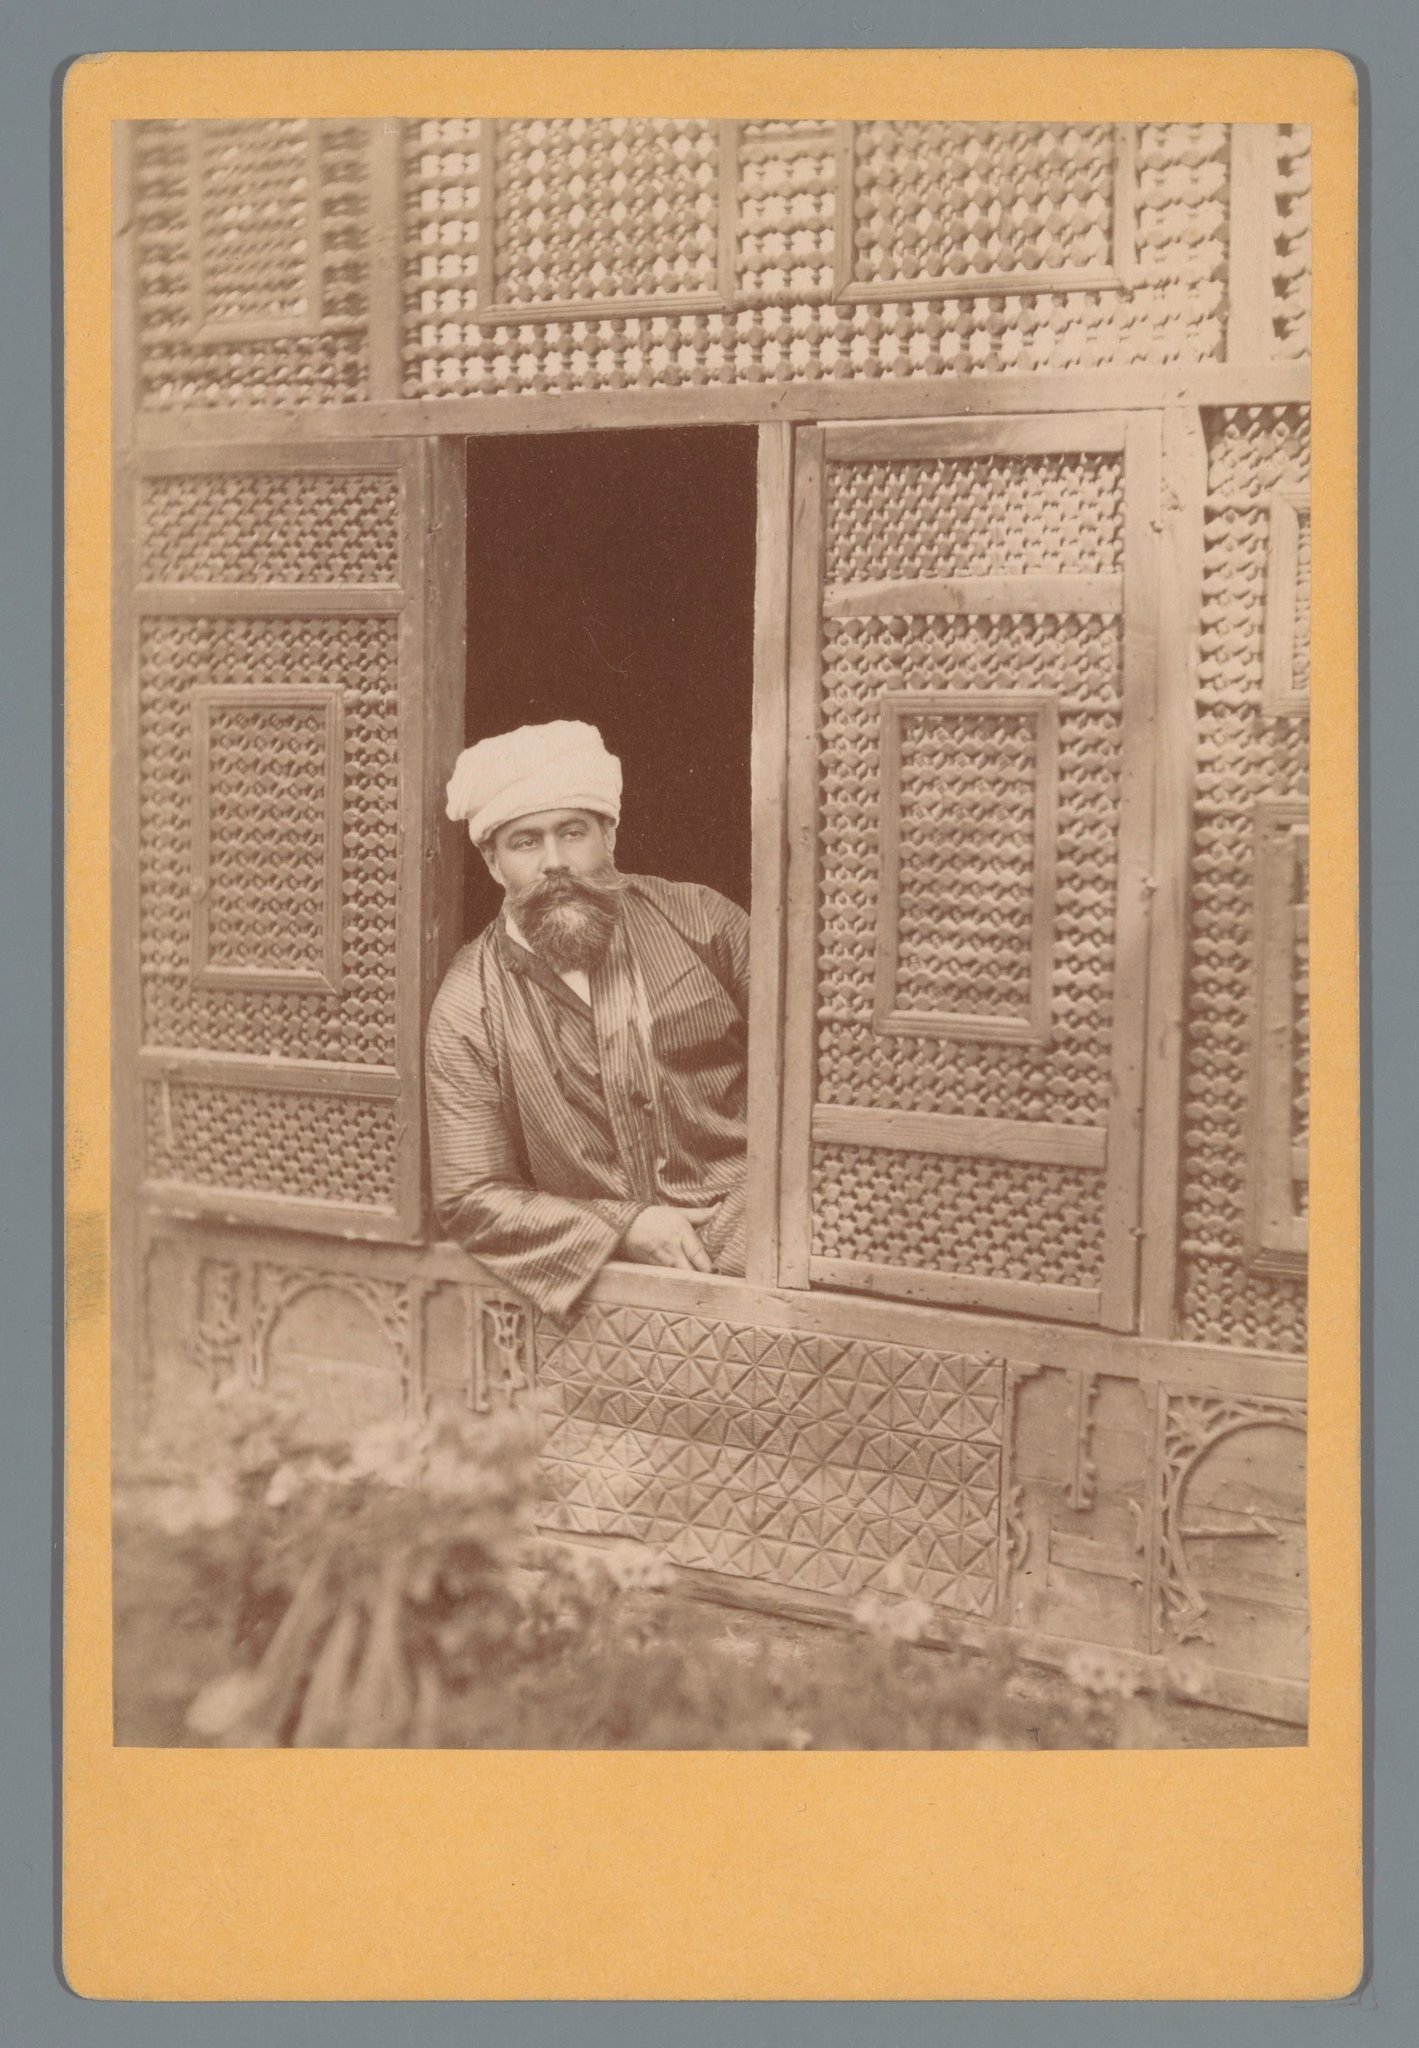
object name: cabinet photograph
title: Man in venster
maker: Anonymous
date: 1880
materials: cardboard, photographic support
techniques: albumen print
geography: cairo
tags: anonymous historical person portrayed, open window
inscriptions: annotation: ‘[...]/ Cairo April 1880’